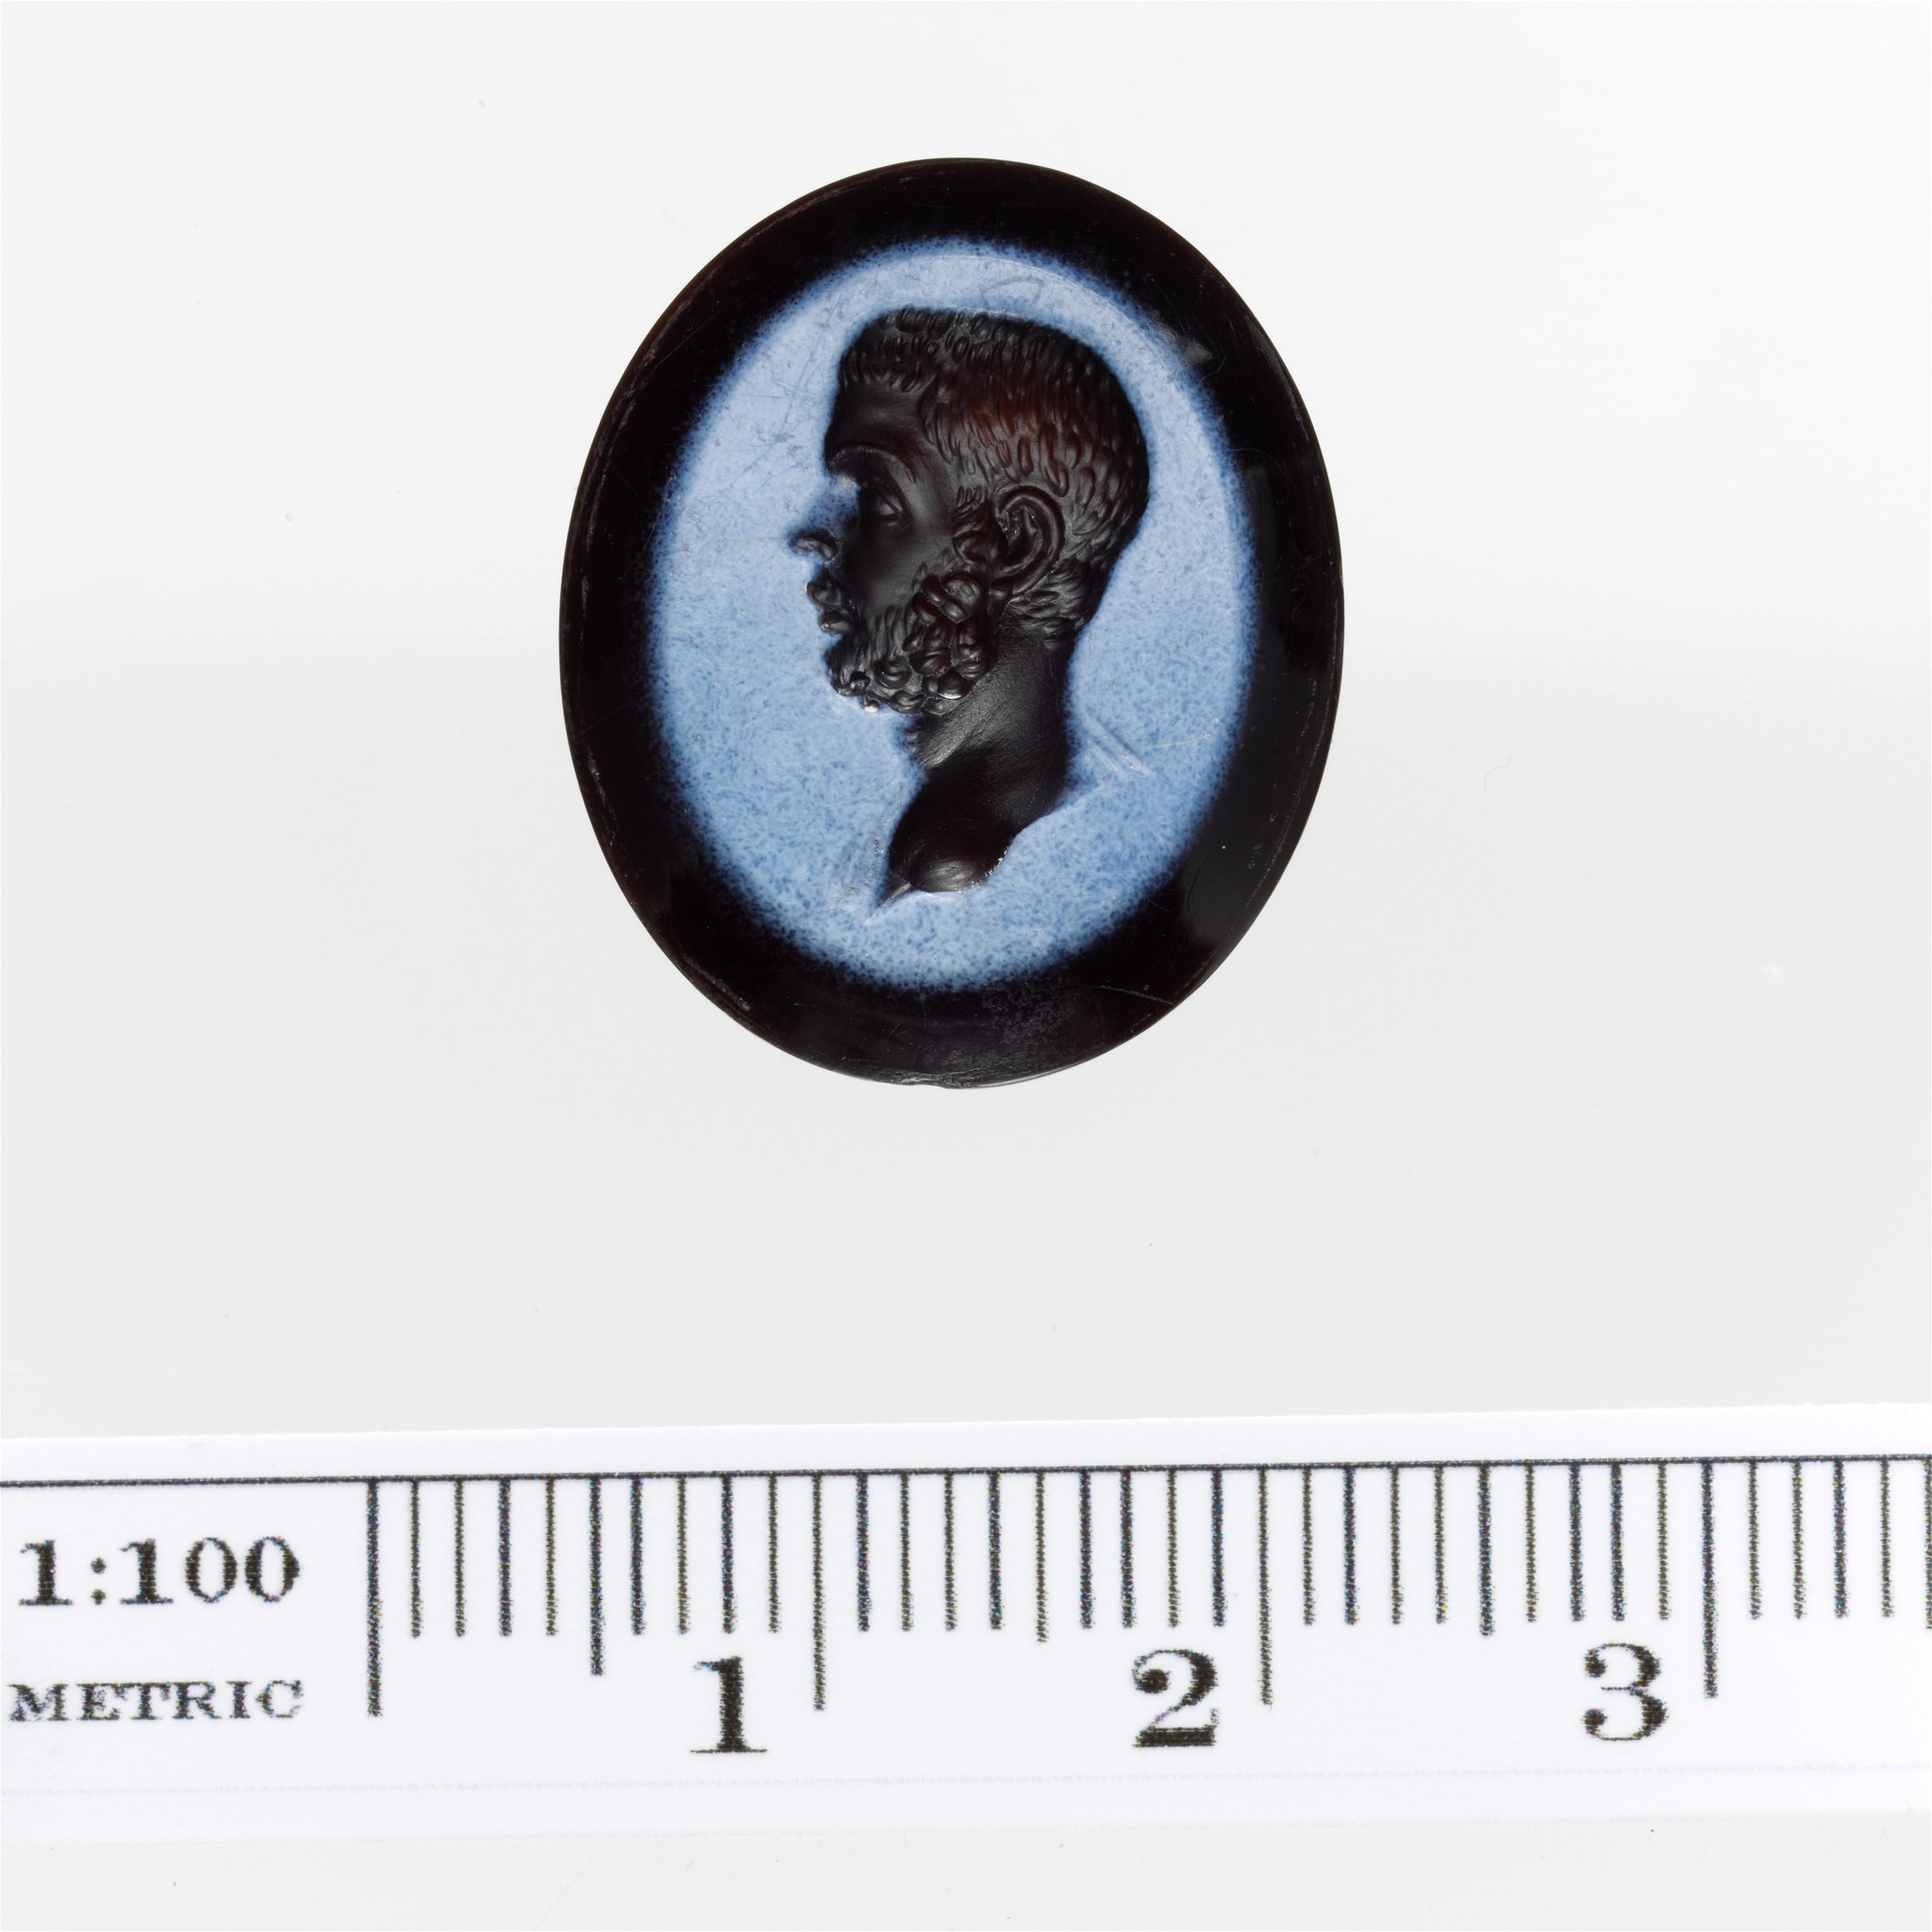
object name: intaglio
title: Nicolo ring stone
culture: roman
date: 234-266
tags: men